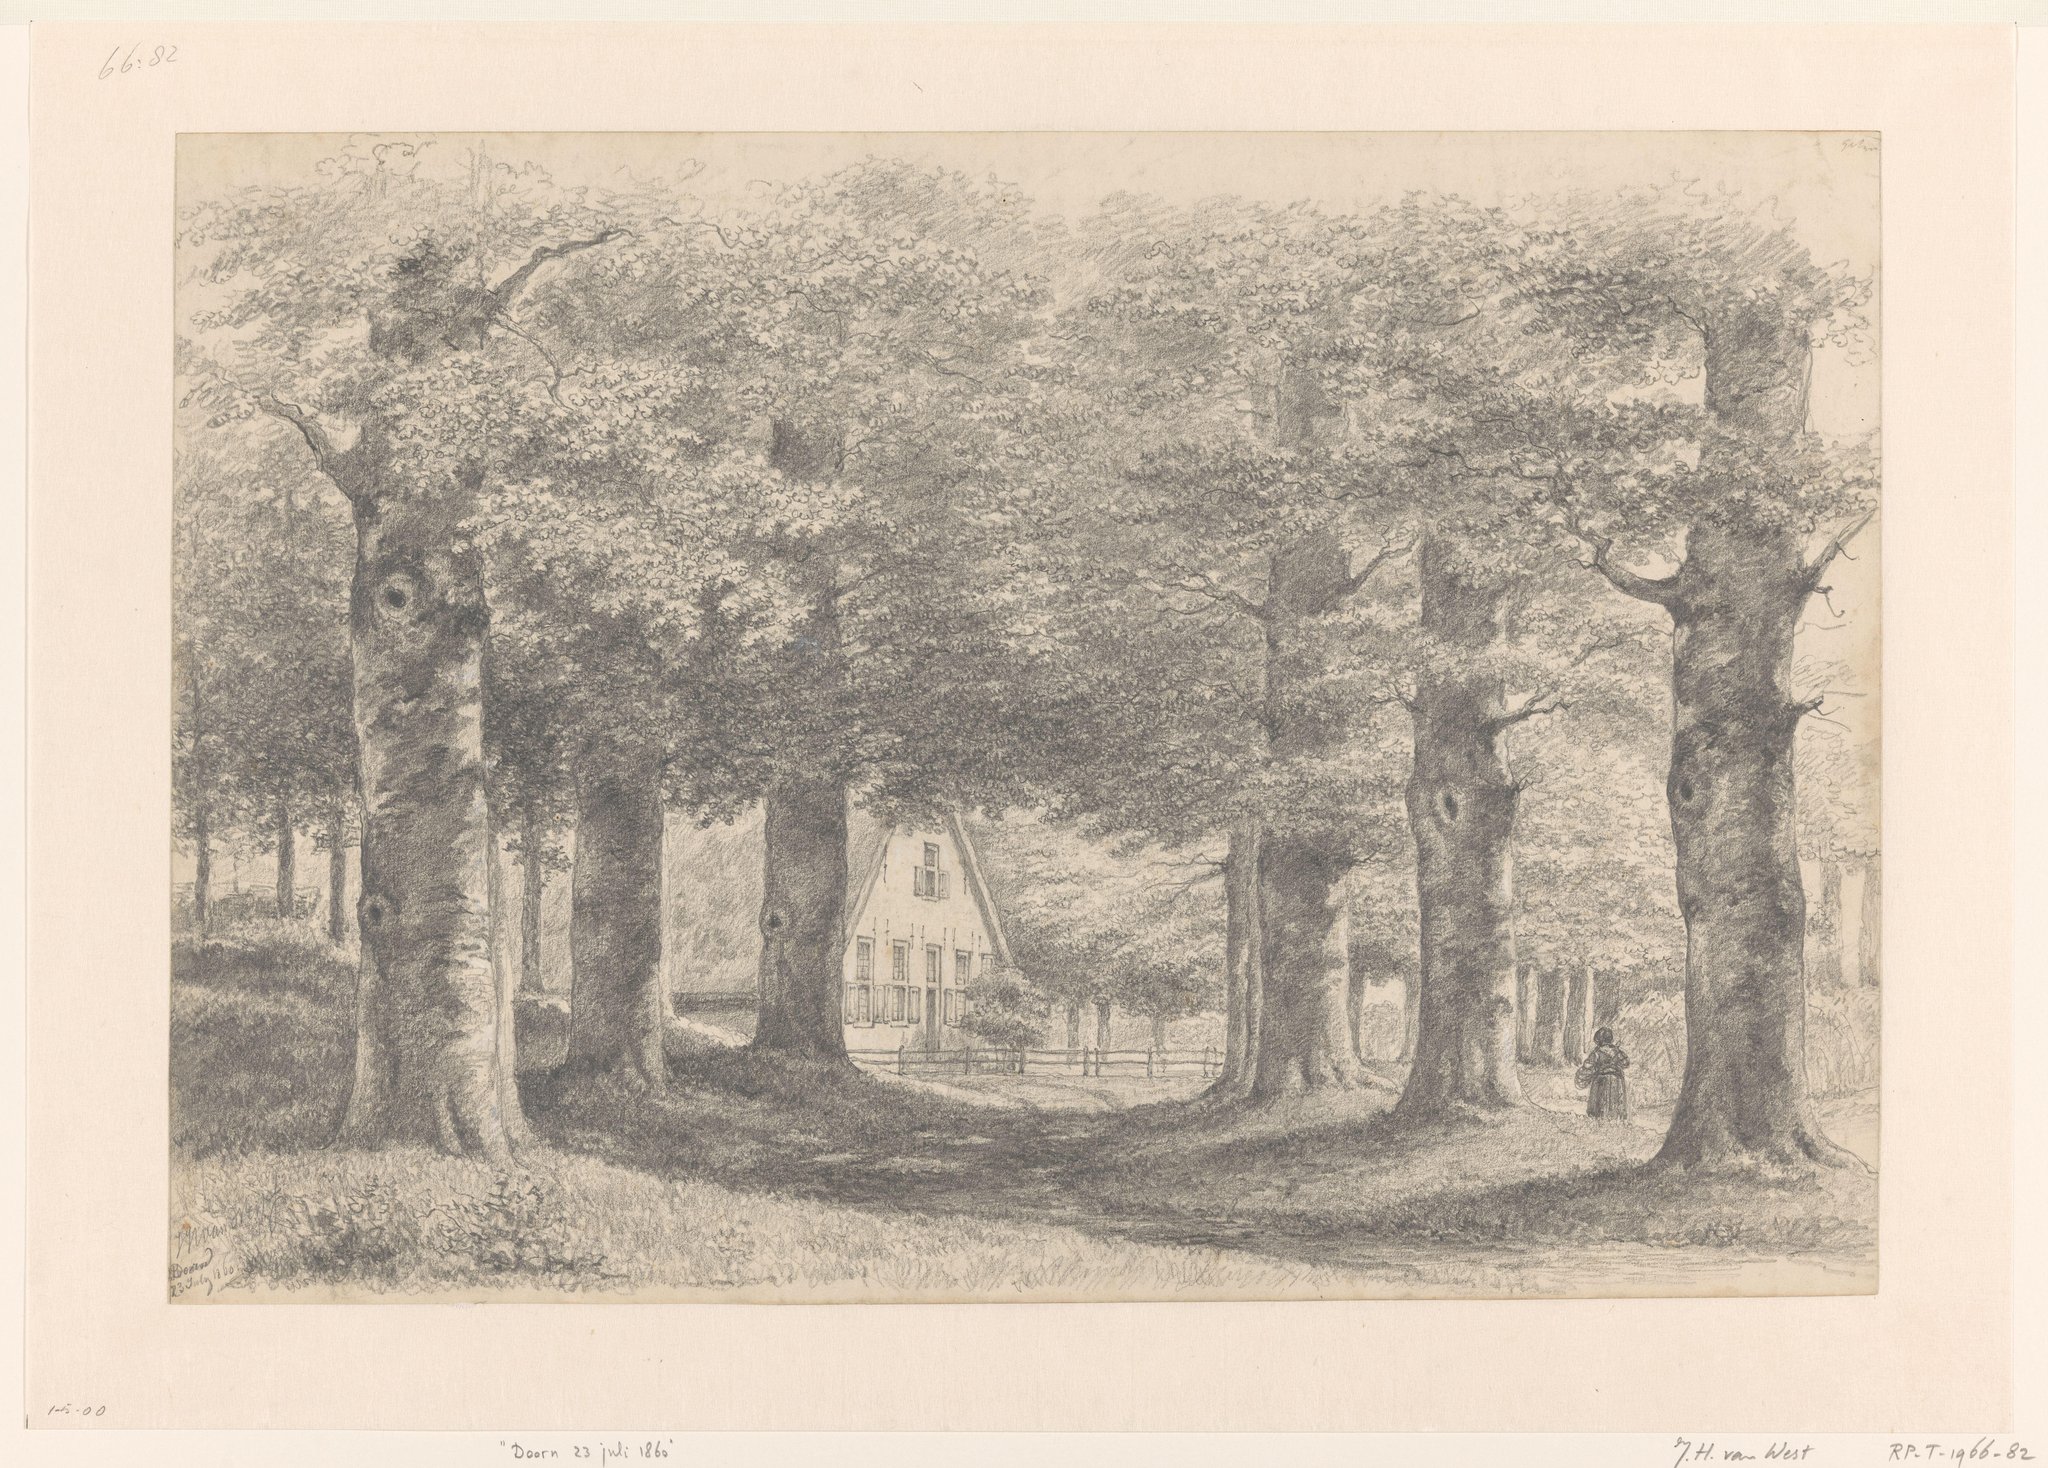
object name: drawing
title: Doorn 23 july 1860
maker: johannes hendrik van west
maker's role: draughtsman, painter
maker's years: 1803-1881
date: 1860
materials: paper, pencil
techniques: drawing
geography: doorn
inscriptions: date